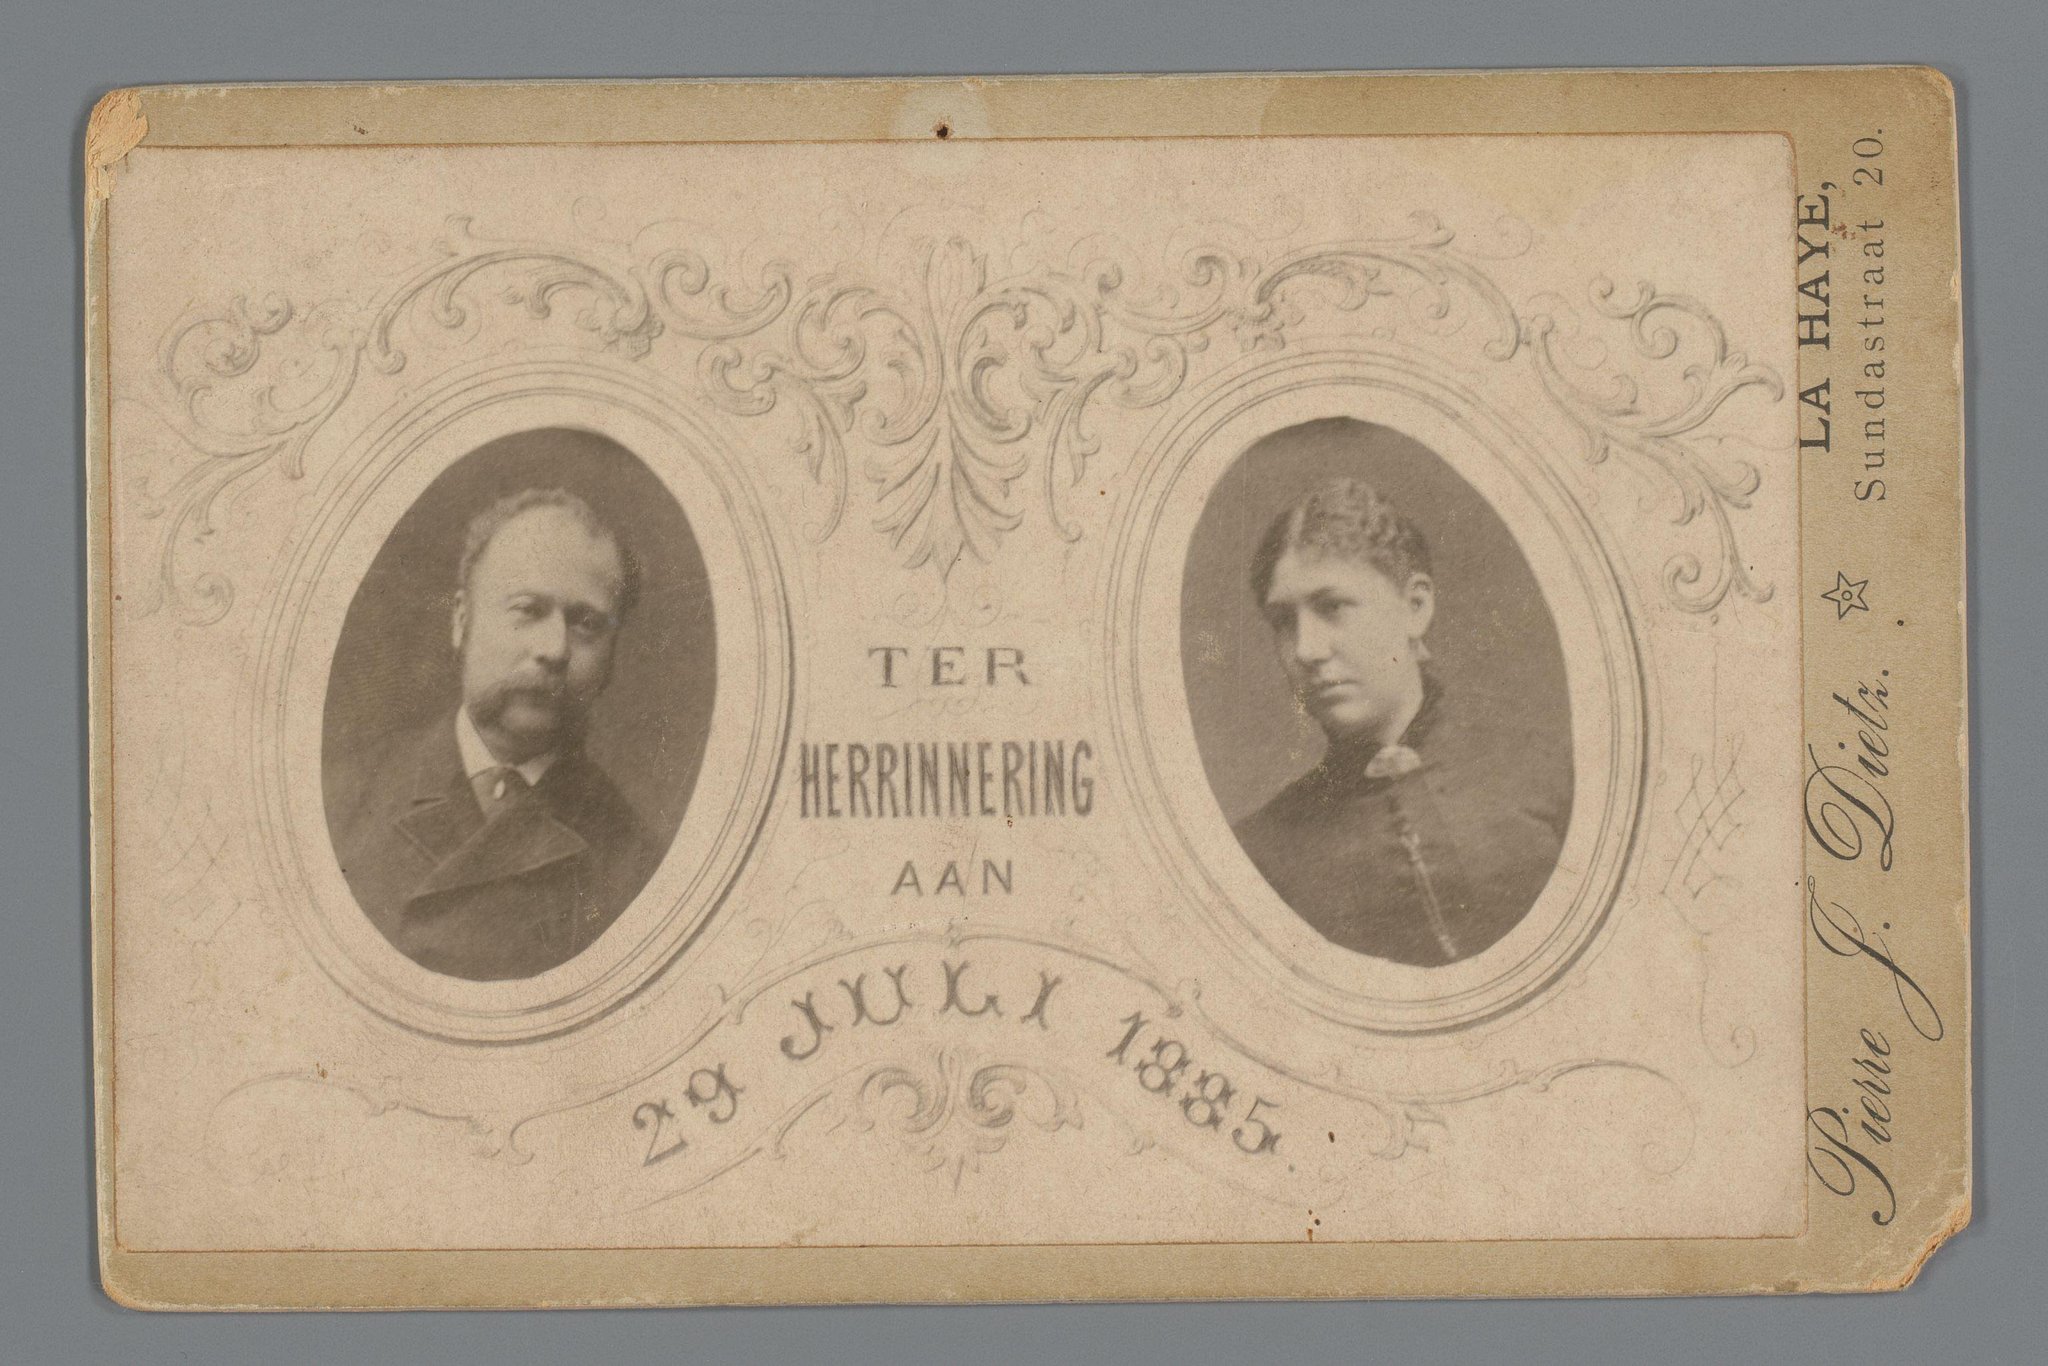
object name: cabinet photograph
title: Ter herinnering aan 29 juli 1885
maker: pierre j. dietz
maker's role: fotograaf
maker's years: 1879-1959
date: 1886-1900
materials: cardboard, paper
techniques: albumen print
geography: the hague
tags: adult woman, adult man, the hague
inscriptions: address: ‘LA HAYE,/ Sundastraat 20.’